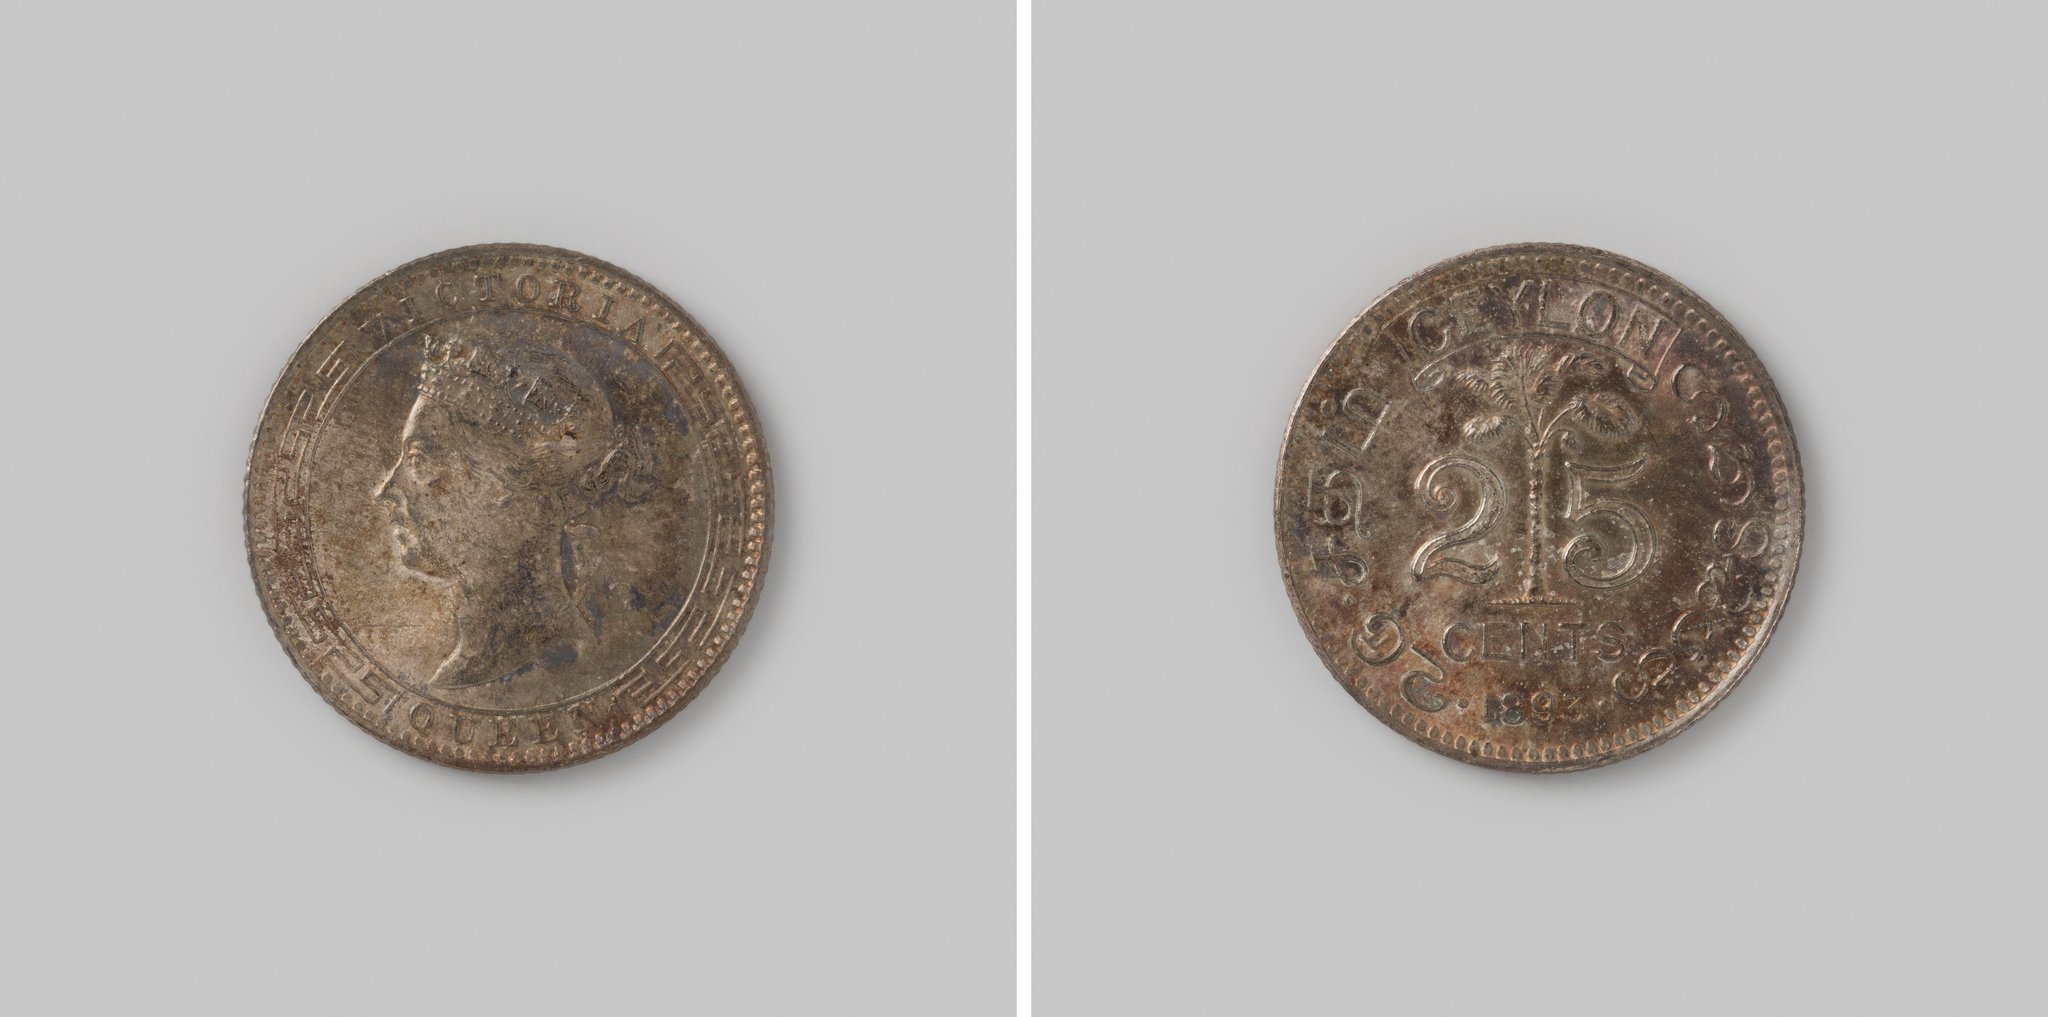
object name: coin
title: 25 cents van Sri Lanka, Ceylon op naam van koningin Victoria, 1893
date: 1893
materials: silver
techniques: striking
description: Zilveren munt. Voorzijde: hoofd met diadeem van de koningin naar links. Keerzijde: tussen waarde-aanduiding - in twee regels - palmboom. Jaartal onderaan. Kartelrand.